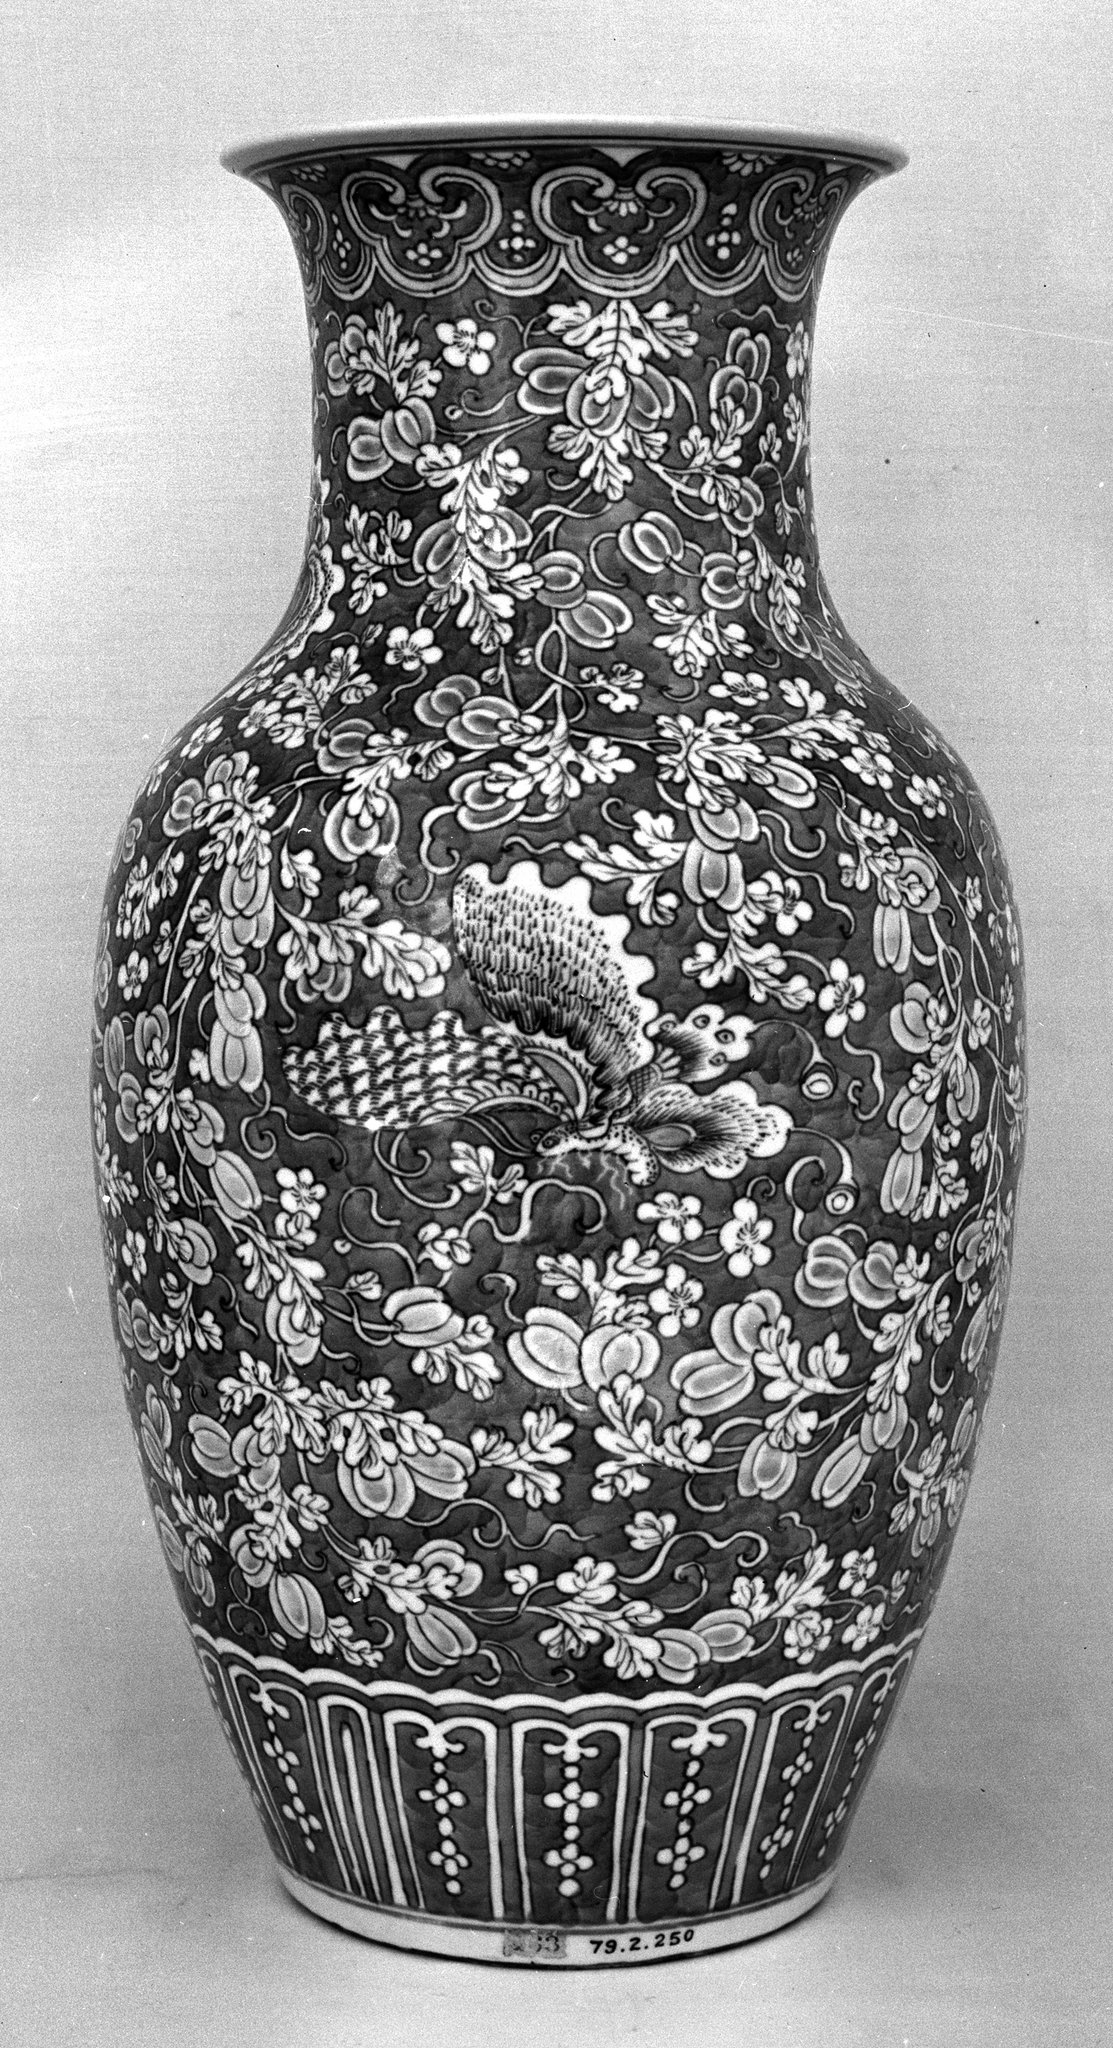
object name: vase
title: Vase with butterflies amid melon vines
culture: chinese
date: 1767-1833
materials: cobalt, porcelain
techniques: painting, underglaze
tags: butterflies